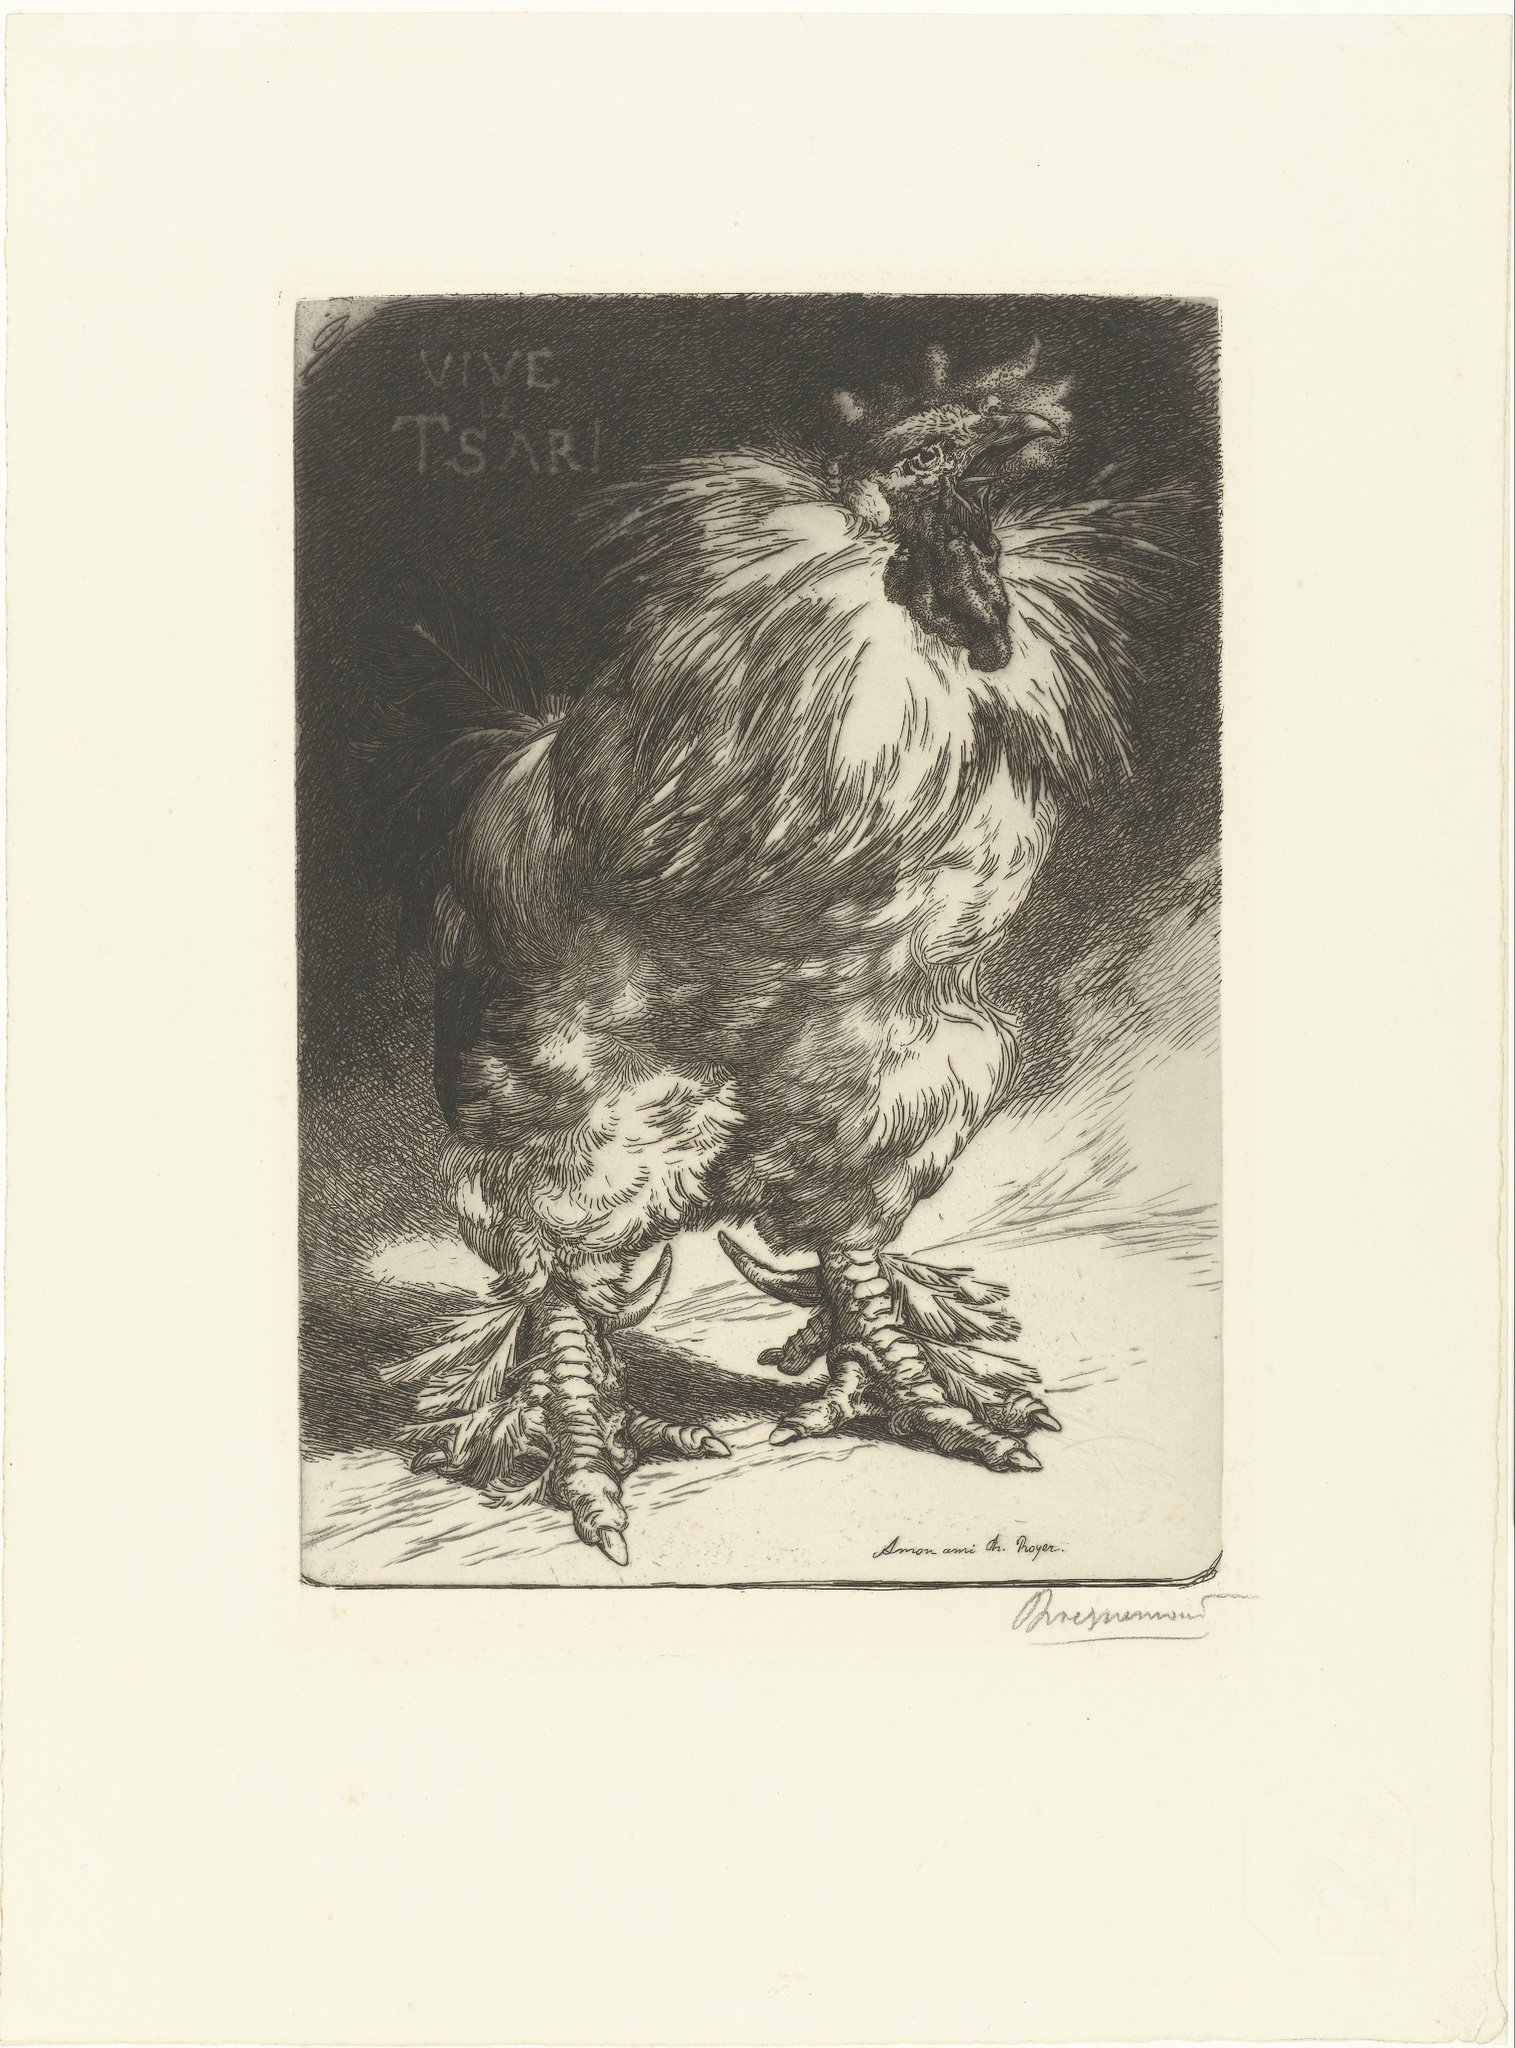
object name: print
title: Vive le Tsar! ou le coq de France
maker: félix bracquemond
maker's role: print maker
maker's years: 1833-1914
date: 1888-1893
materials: paper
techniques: etching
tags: fowl (cock, hen, chicken, etc.)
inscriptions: collector's mark: Lugt 2760, dedication: ‘A mon ami dr. Royer’, collector's mark: Lugt 2233, collector's mark: Lugt 2228, check stamp: Lugt 819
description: Gedrukt in oplage van honderd exemplaren voor album L'Estampe originale, 1893. Niet beschreven bij Beraldi 1885.